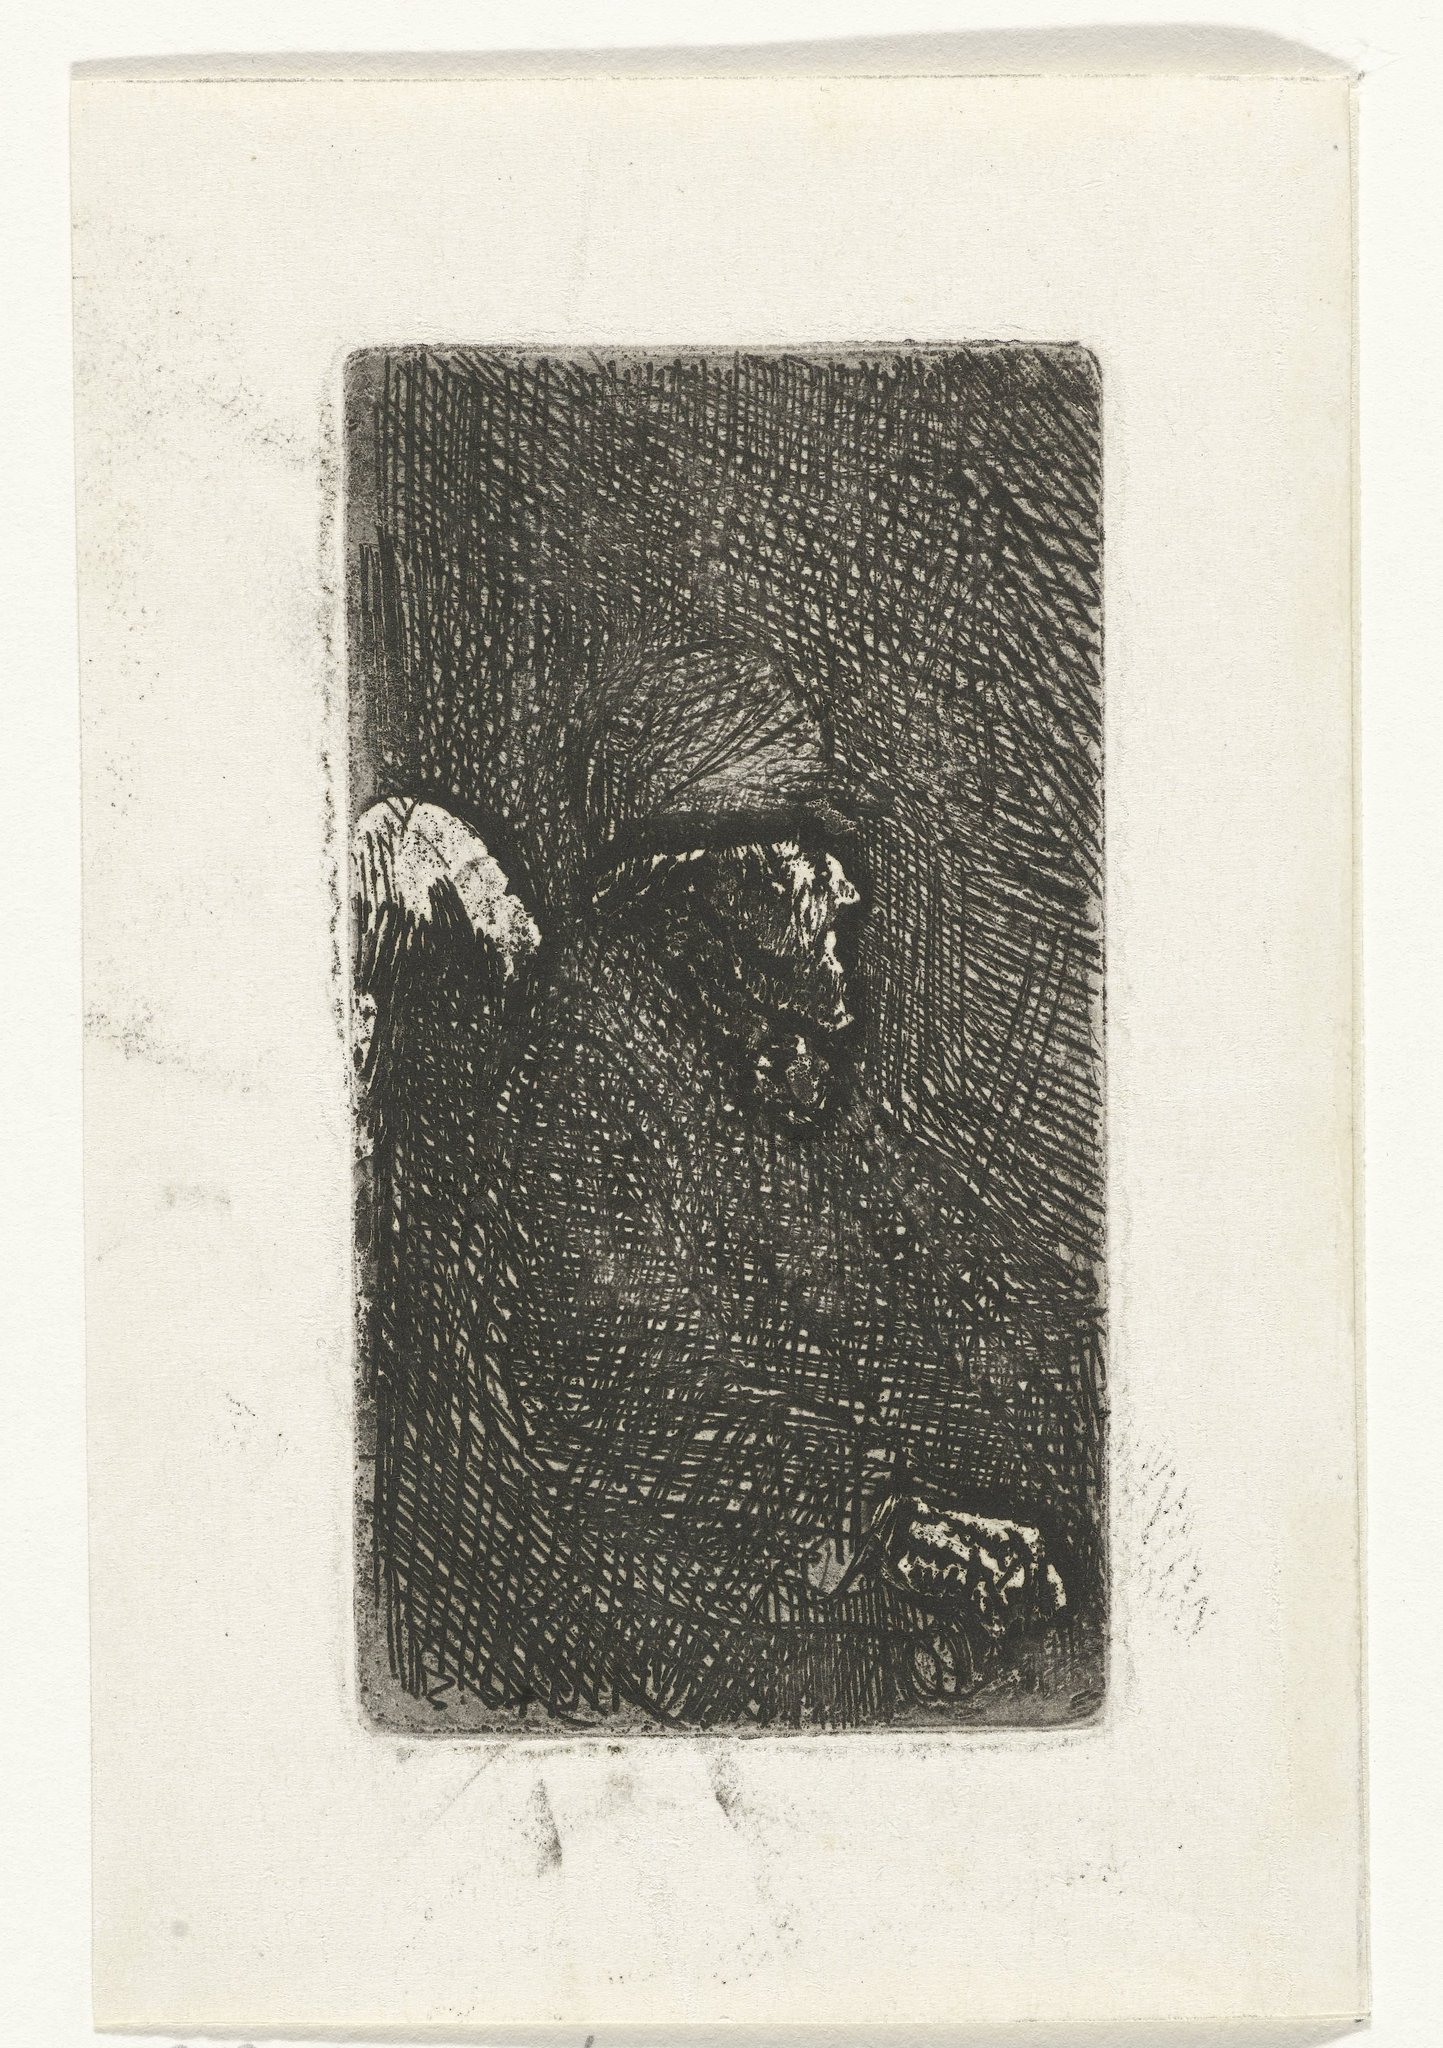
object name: print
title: Zittende oude man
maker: jozef israëls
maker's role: draughtsman, painter, print maker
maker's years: 1824-1911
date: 1835-1888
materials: paper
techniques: etching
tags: sitting figure, head-gear: cap (+ men's clothes), old man (+ sideview, profile)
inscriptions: collector's mark: Lugt 2228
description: Buste van een zittende oude man met een pet op het hoofd, en profil naar rechts.